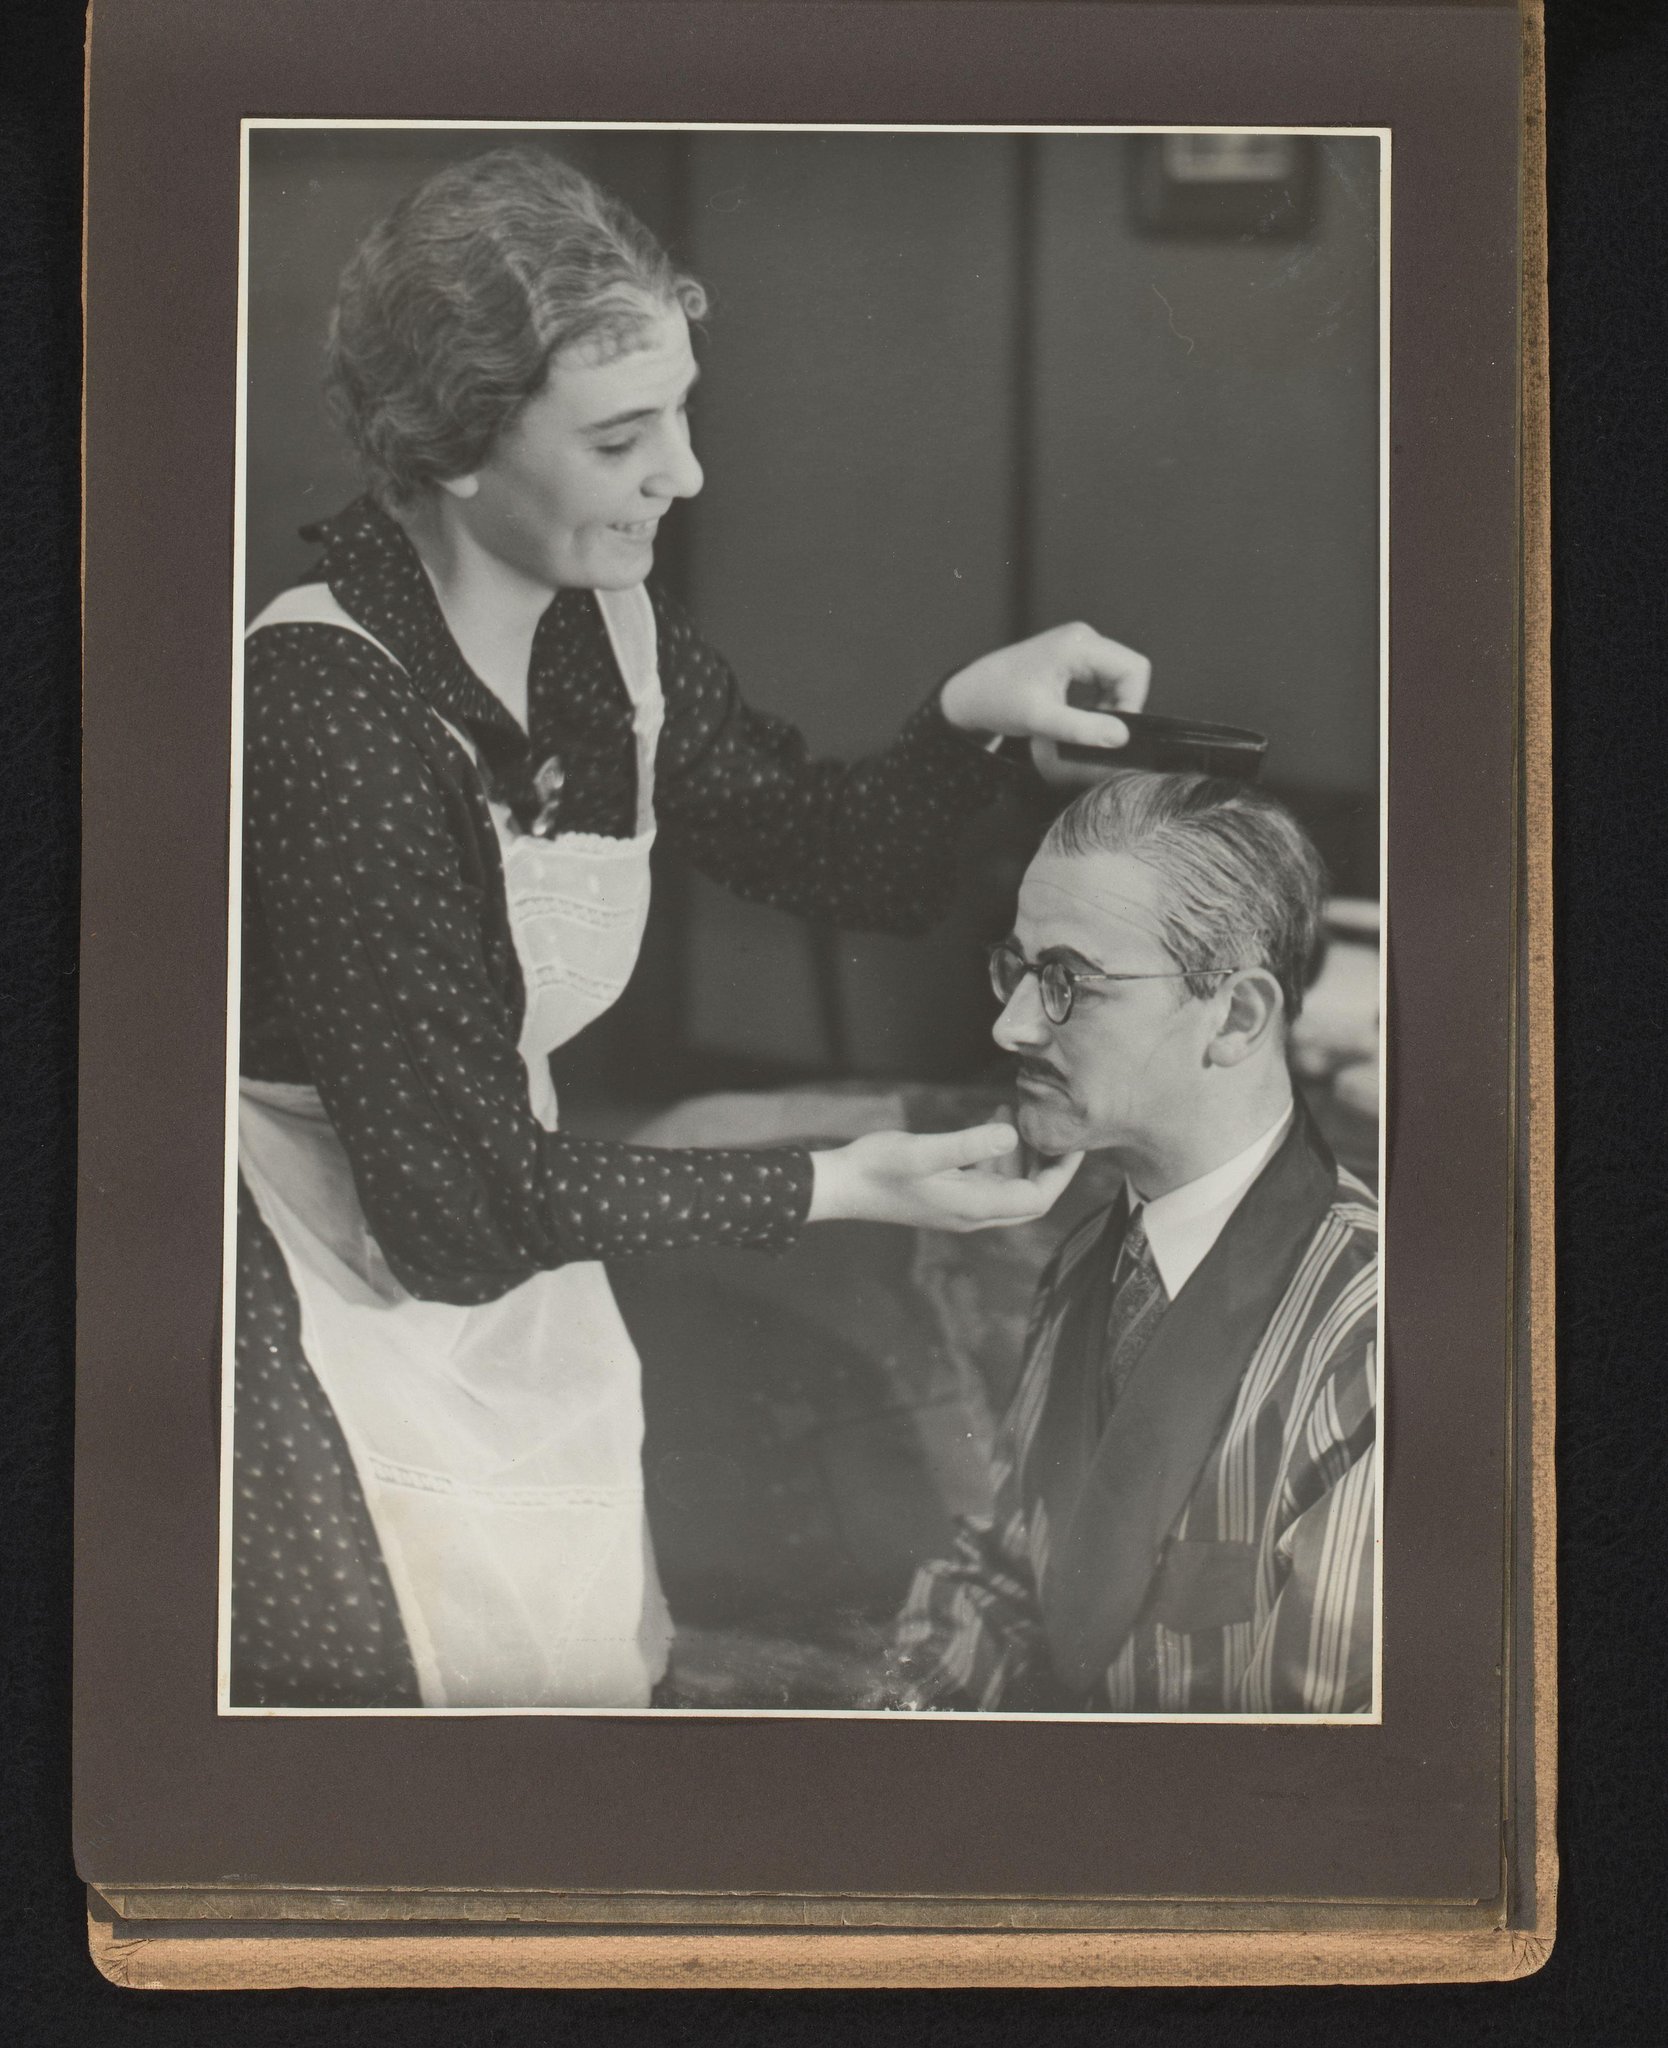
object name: photograph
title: Een scène uit het toneelstuk 'Wat Jonas overkwam'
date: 1936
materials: paper, photographic support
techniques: gelatin silver print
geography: haarlem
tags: theatre, theatrical performance, students' organization, vocational education, e.g.: junior technical school, haarlem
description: Albumblad met een foto van een scène uit de opvoering van het toneelstuk 'Wat Jonas overkwam' op 22 februari 1936. Scène met een man en een vrouw. Onderdeel van het fotoalbum 'Jaarfeesten van het Corps M.T.S. te Haarlem'.